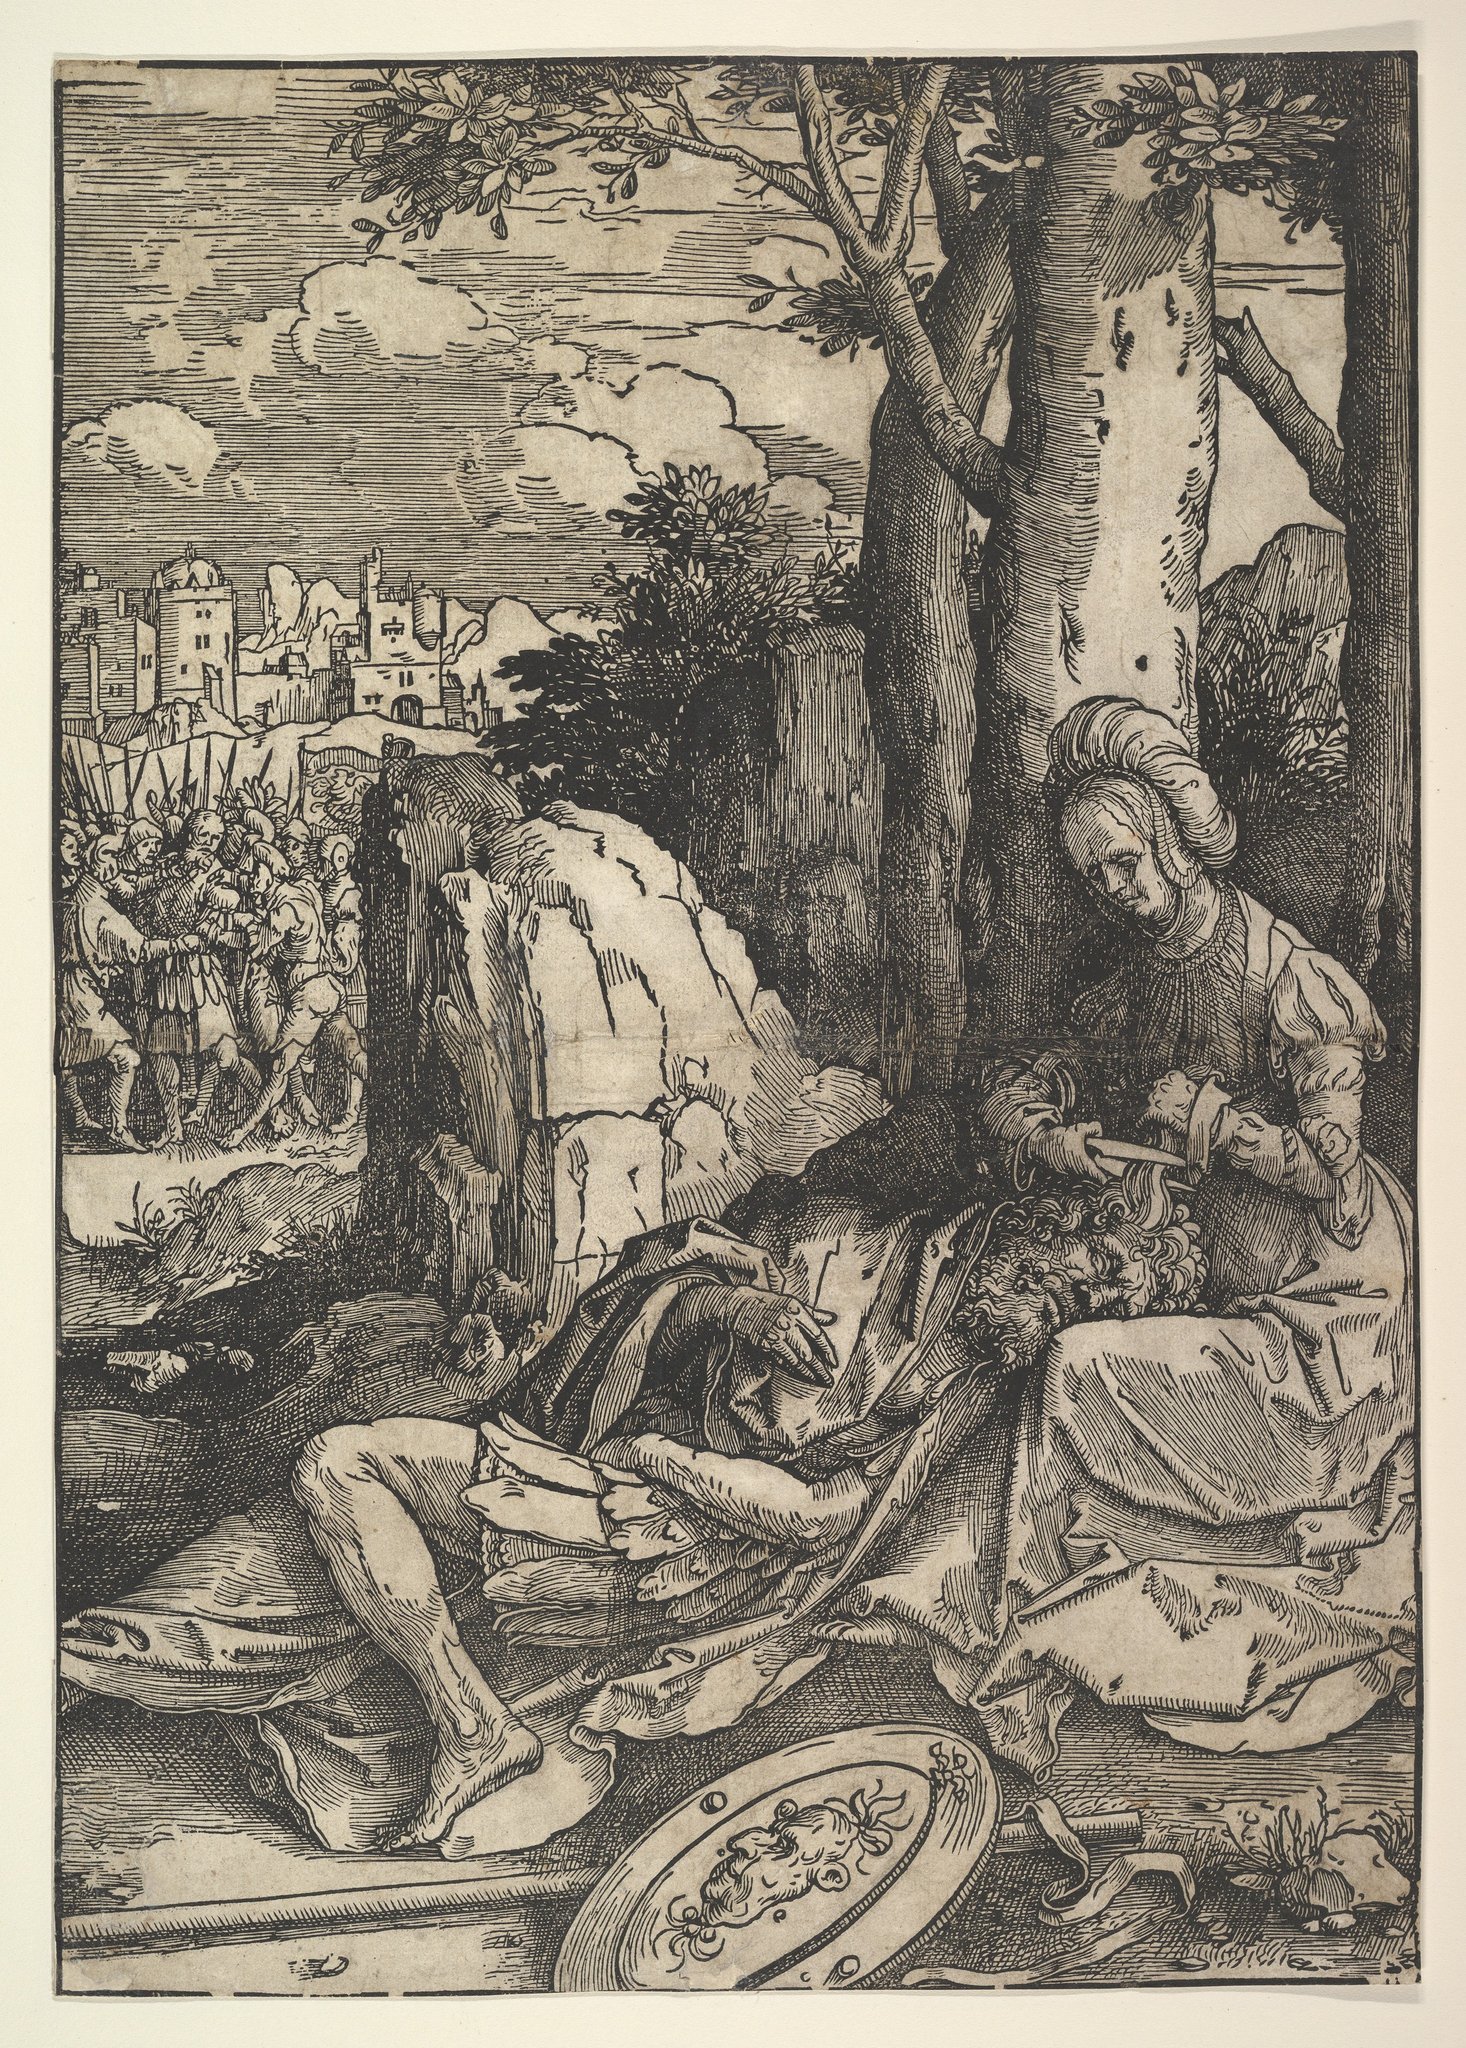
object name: print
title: Samson and Delilah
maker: lucas van leyden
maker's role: artist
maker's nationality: netherlandish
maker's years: 1494-1533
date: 1514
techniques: woodcut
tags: buildings,women,trees,samson